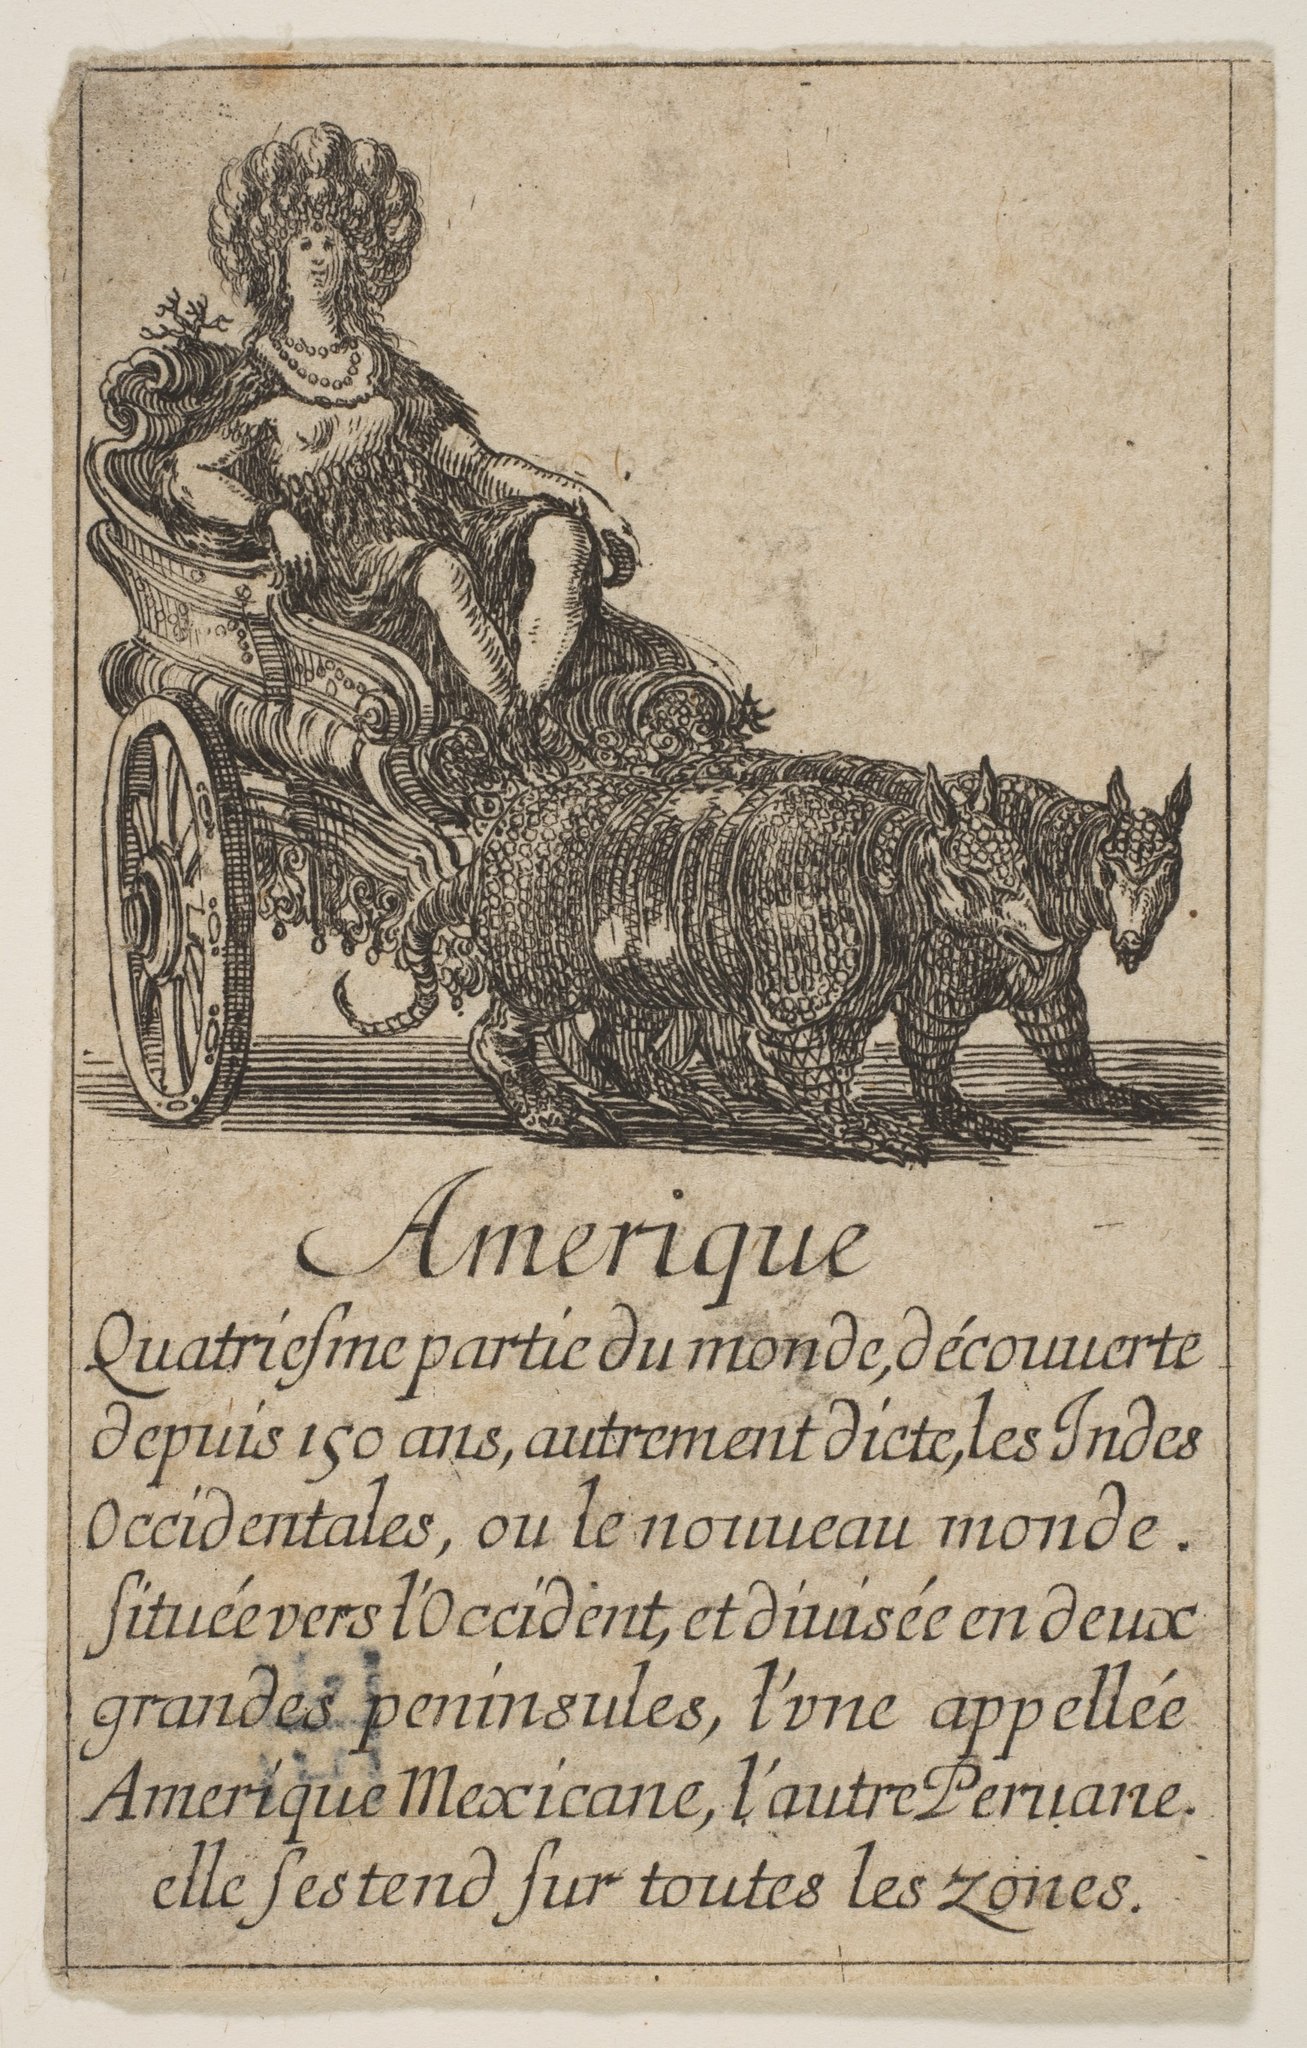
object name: print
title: Allegory of America, from the playing cards "Jeu de la Géographie"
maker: stefano della bella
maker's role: artist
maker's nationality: italian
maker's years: 1610-1664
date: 1644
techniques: etching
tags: animals,women,allegory